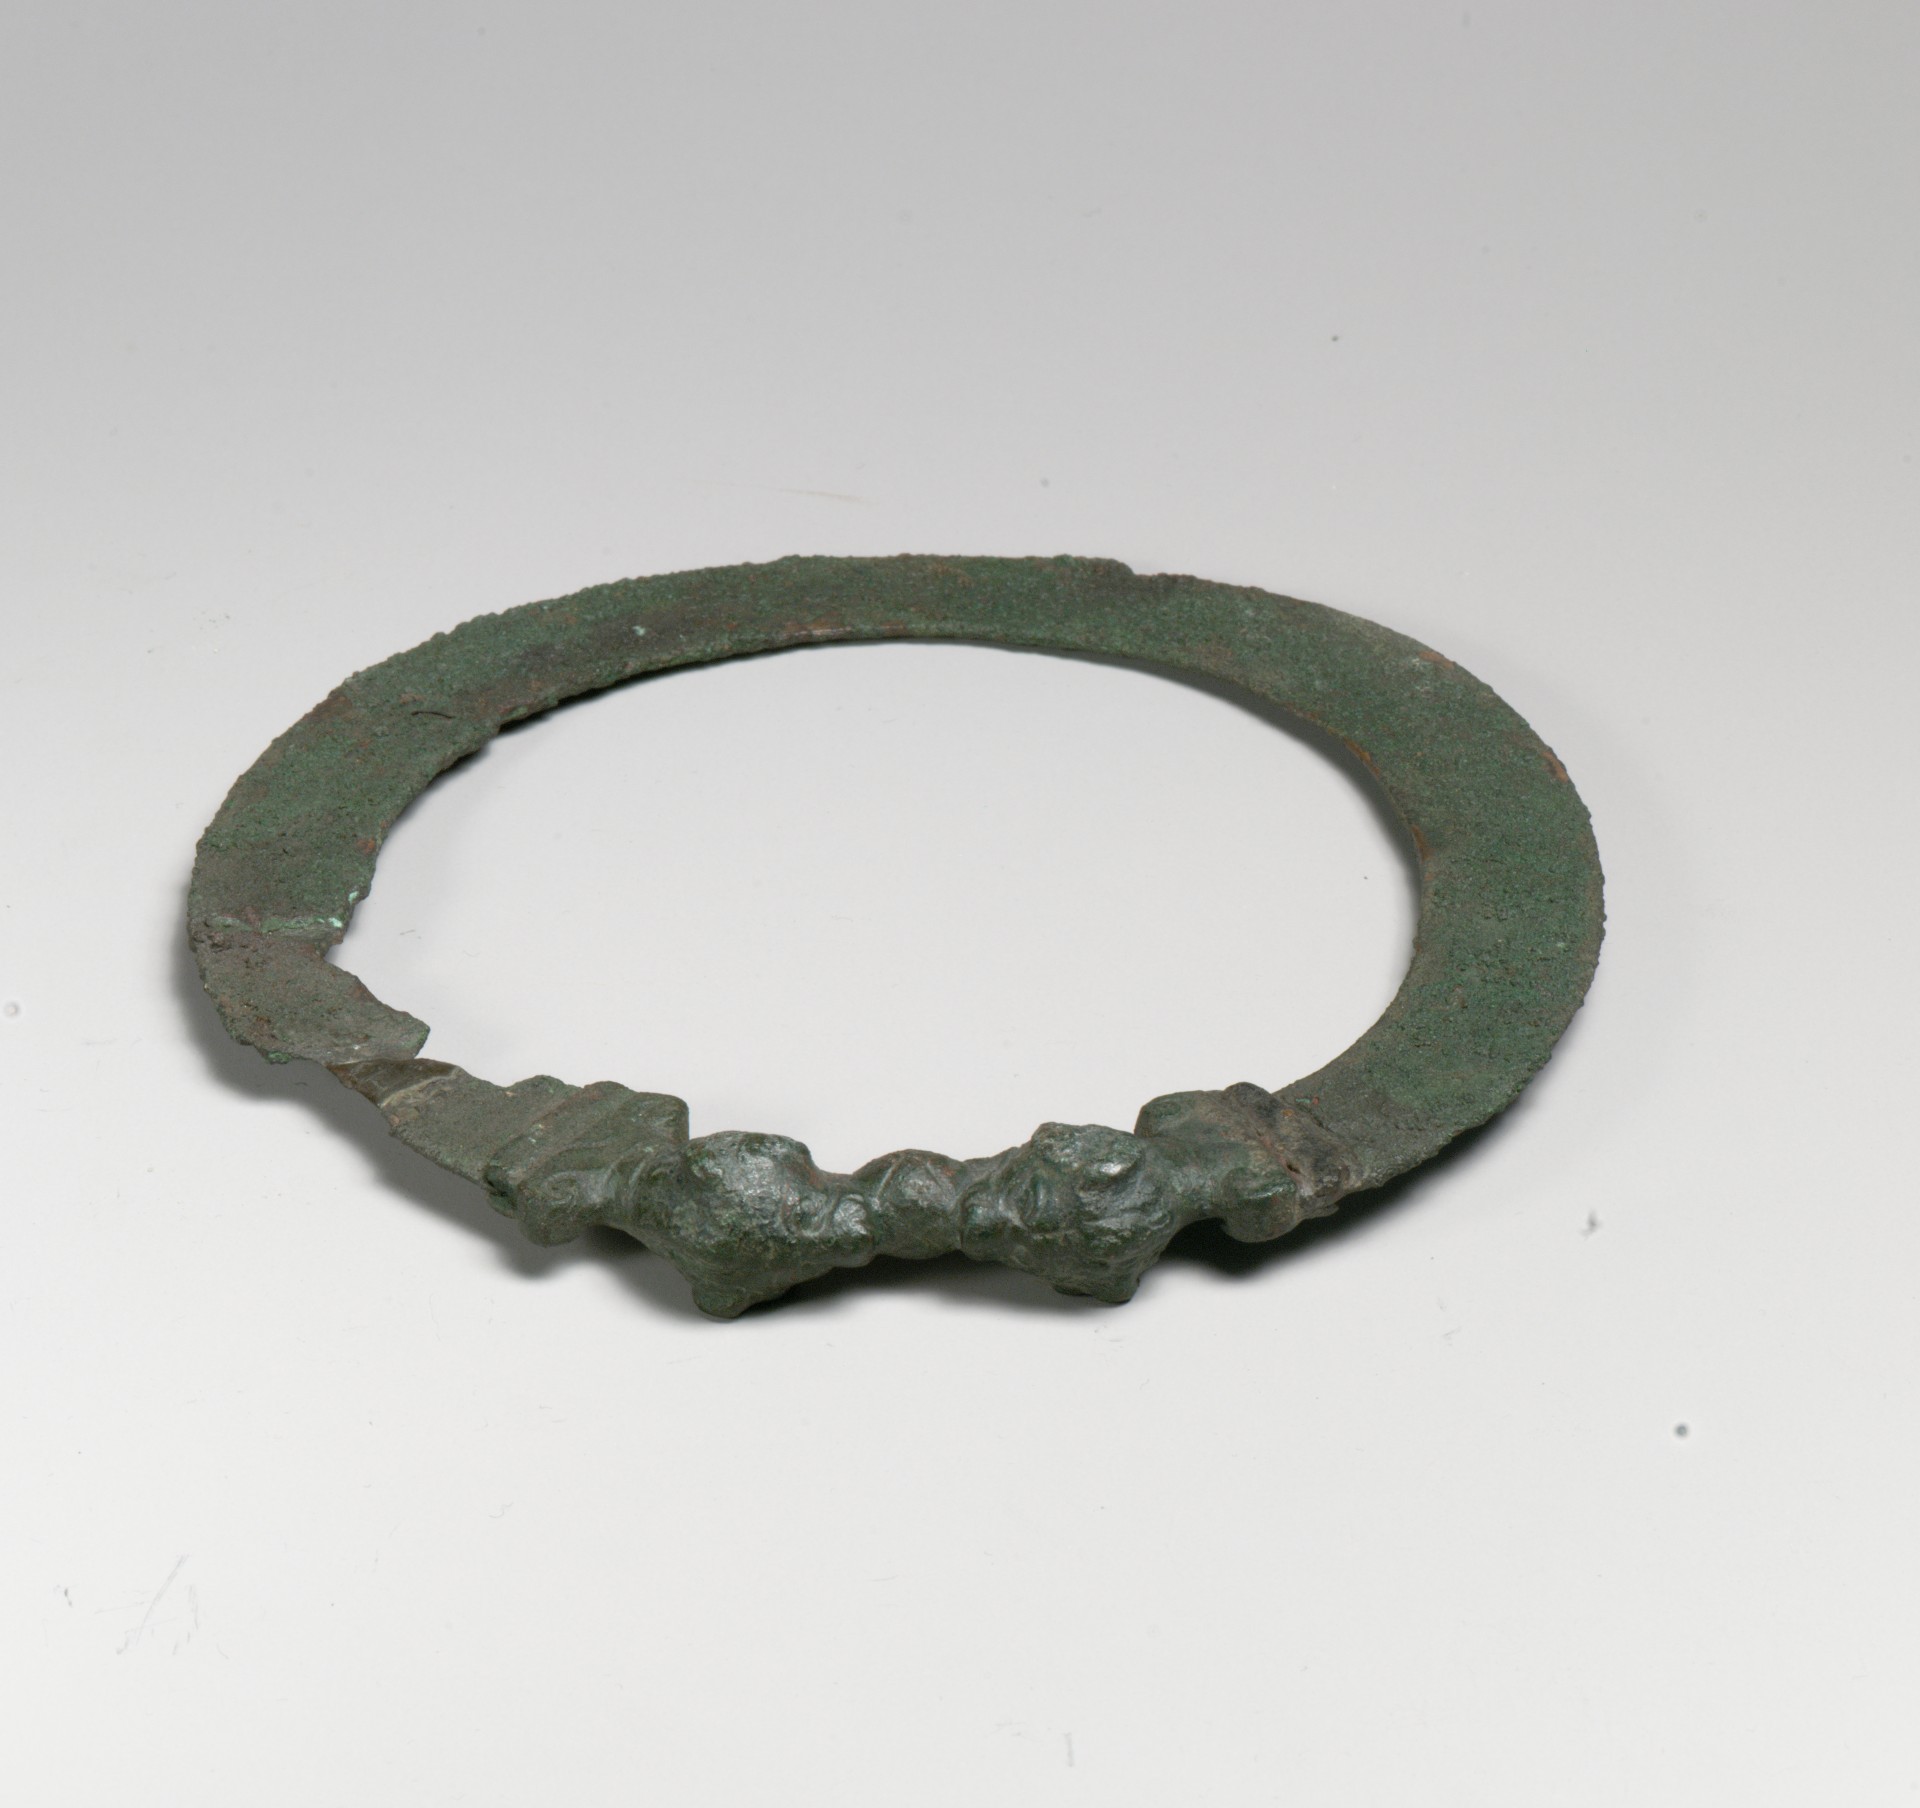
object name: ring with lion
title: Ring for the attachment of bath implements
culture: roman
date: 1-200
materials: bronze